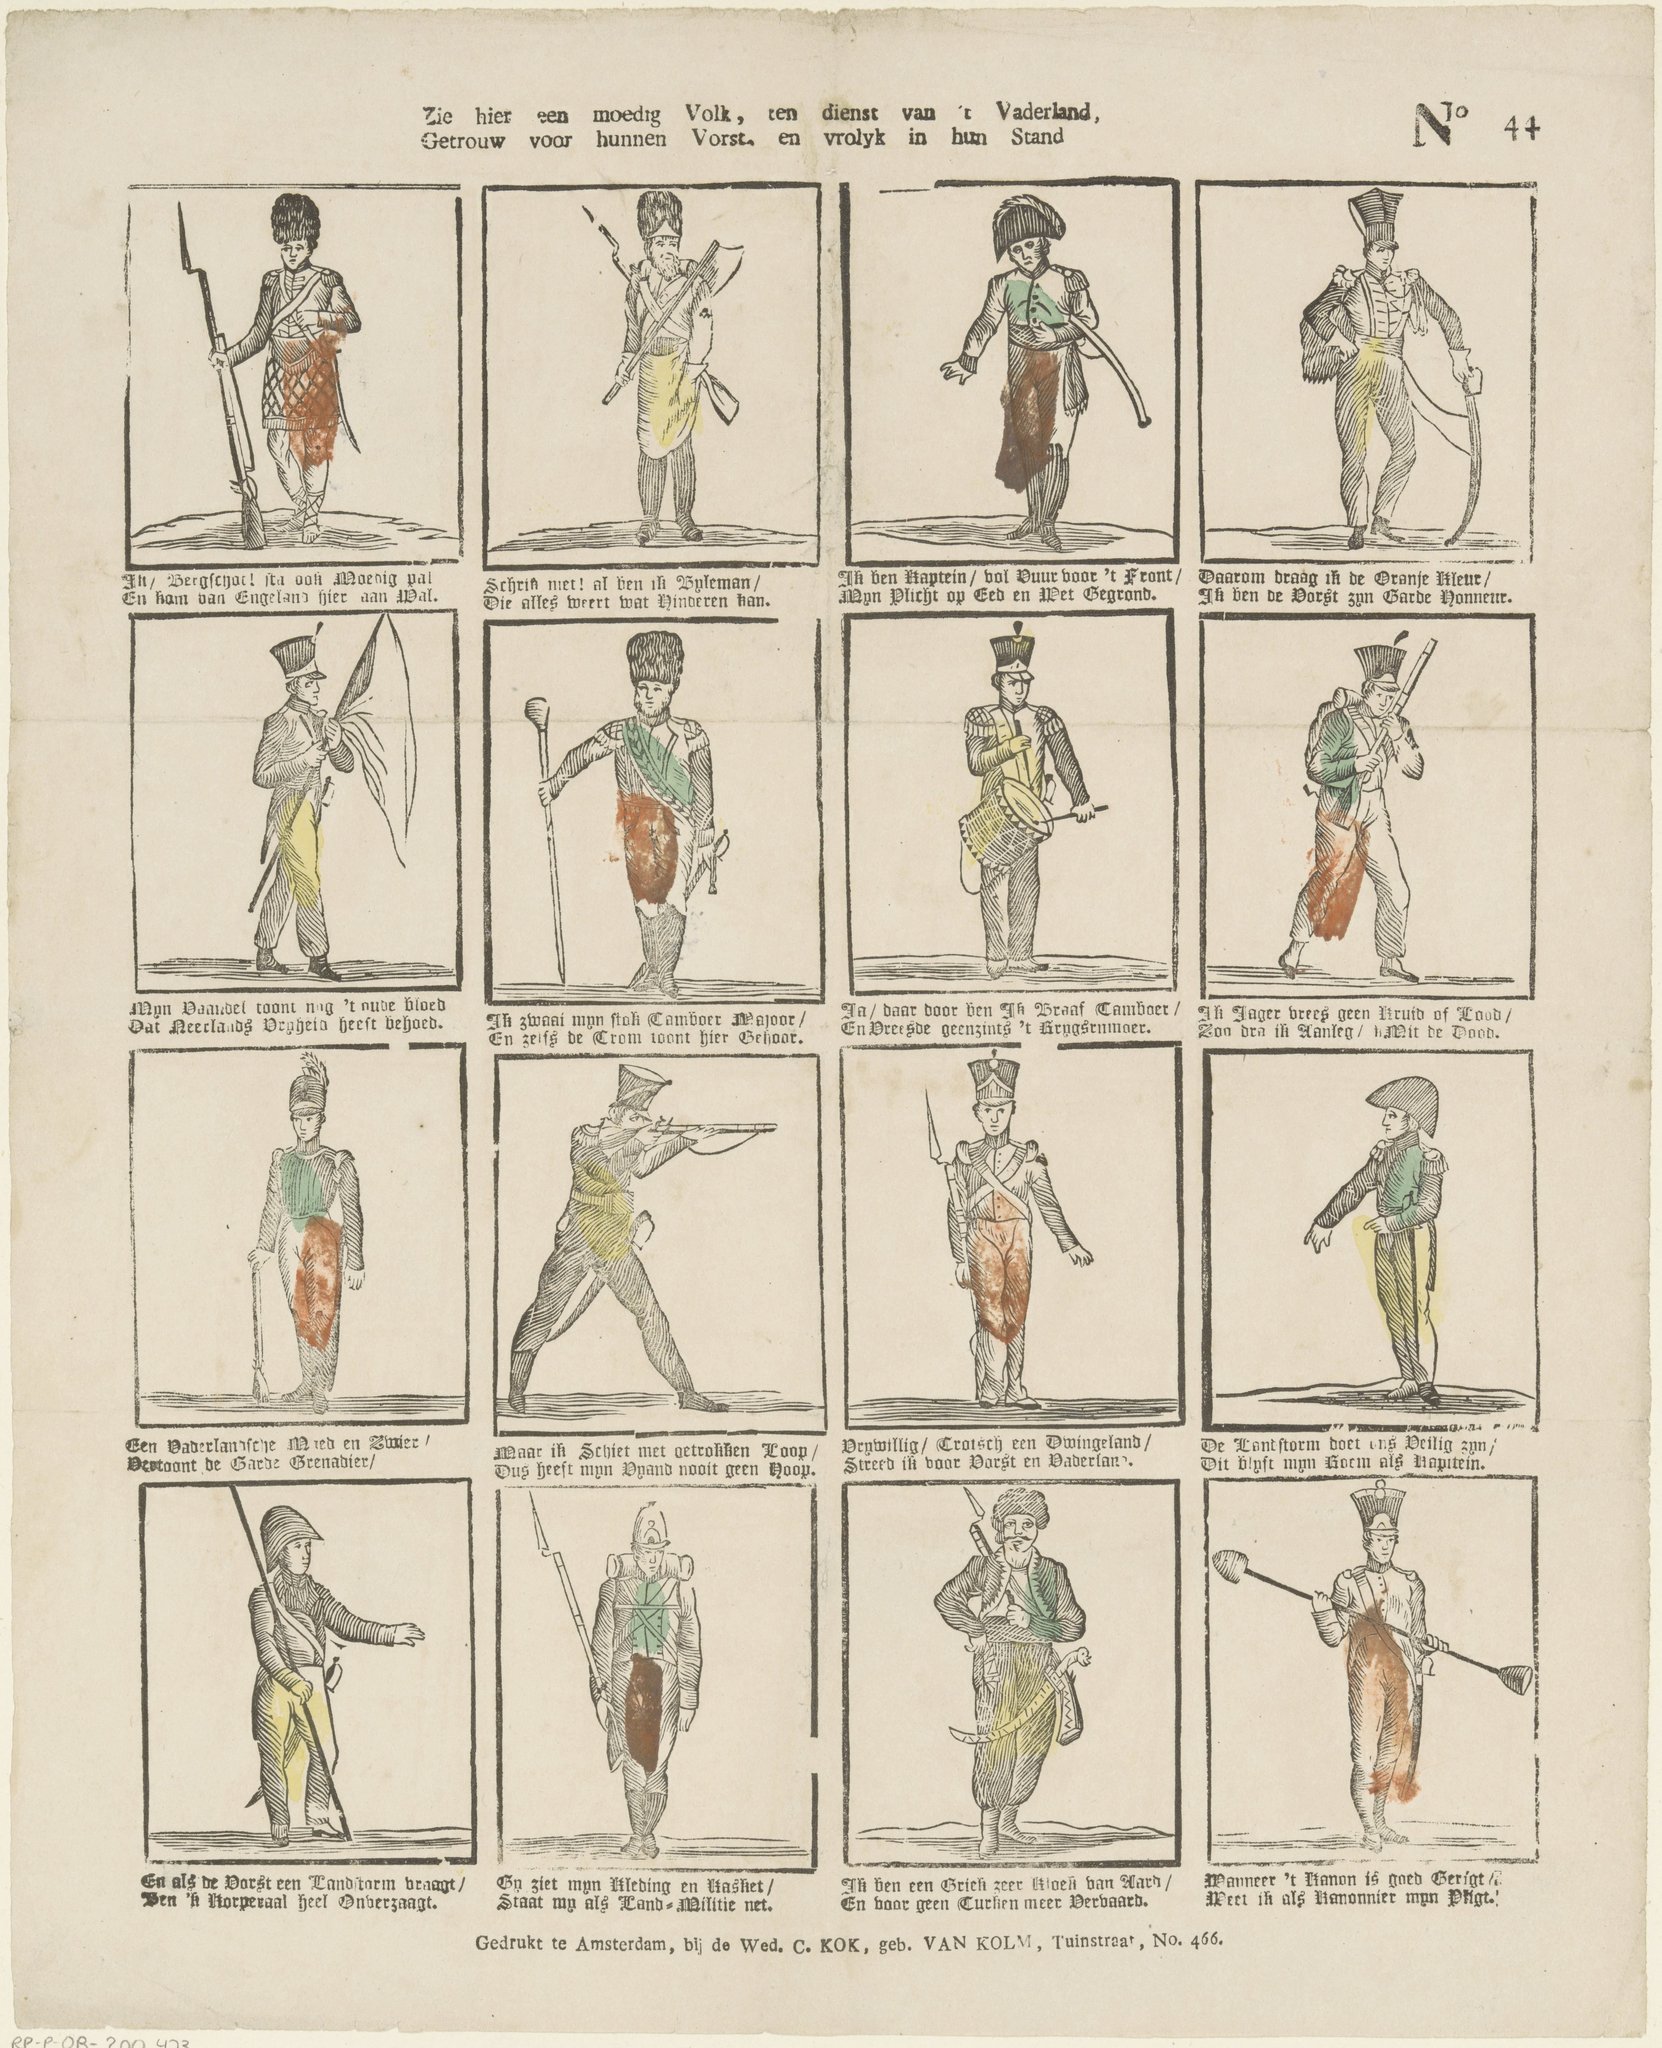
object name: print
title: Zie hier een moedig volk, ten dienst van 't vaderland, / Getrouw voor hunnen vorst, en vrolyk in hun strand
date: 1842-1866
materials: paper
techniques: colour, letterpress printing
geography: amsterdam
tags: weapons, the soldier; the soldier's life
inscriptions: collector's mark: Lugt 2760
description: Blad met 16 voorstellingen van militairen met wapens en instrumenten. Onder elke afbeelding een tweeregelig vers. Genummerd rechtsboven: No. 44.